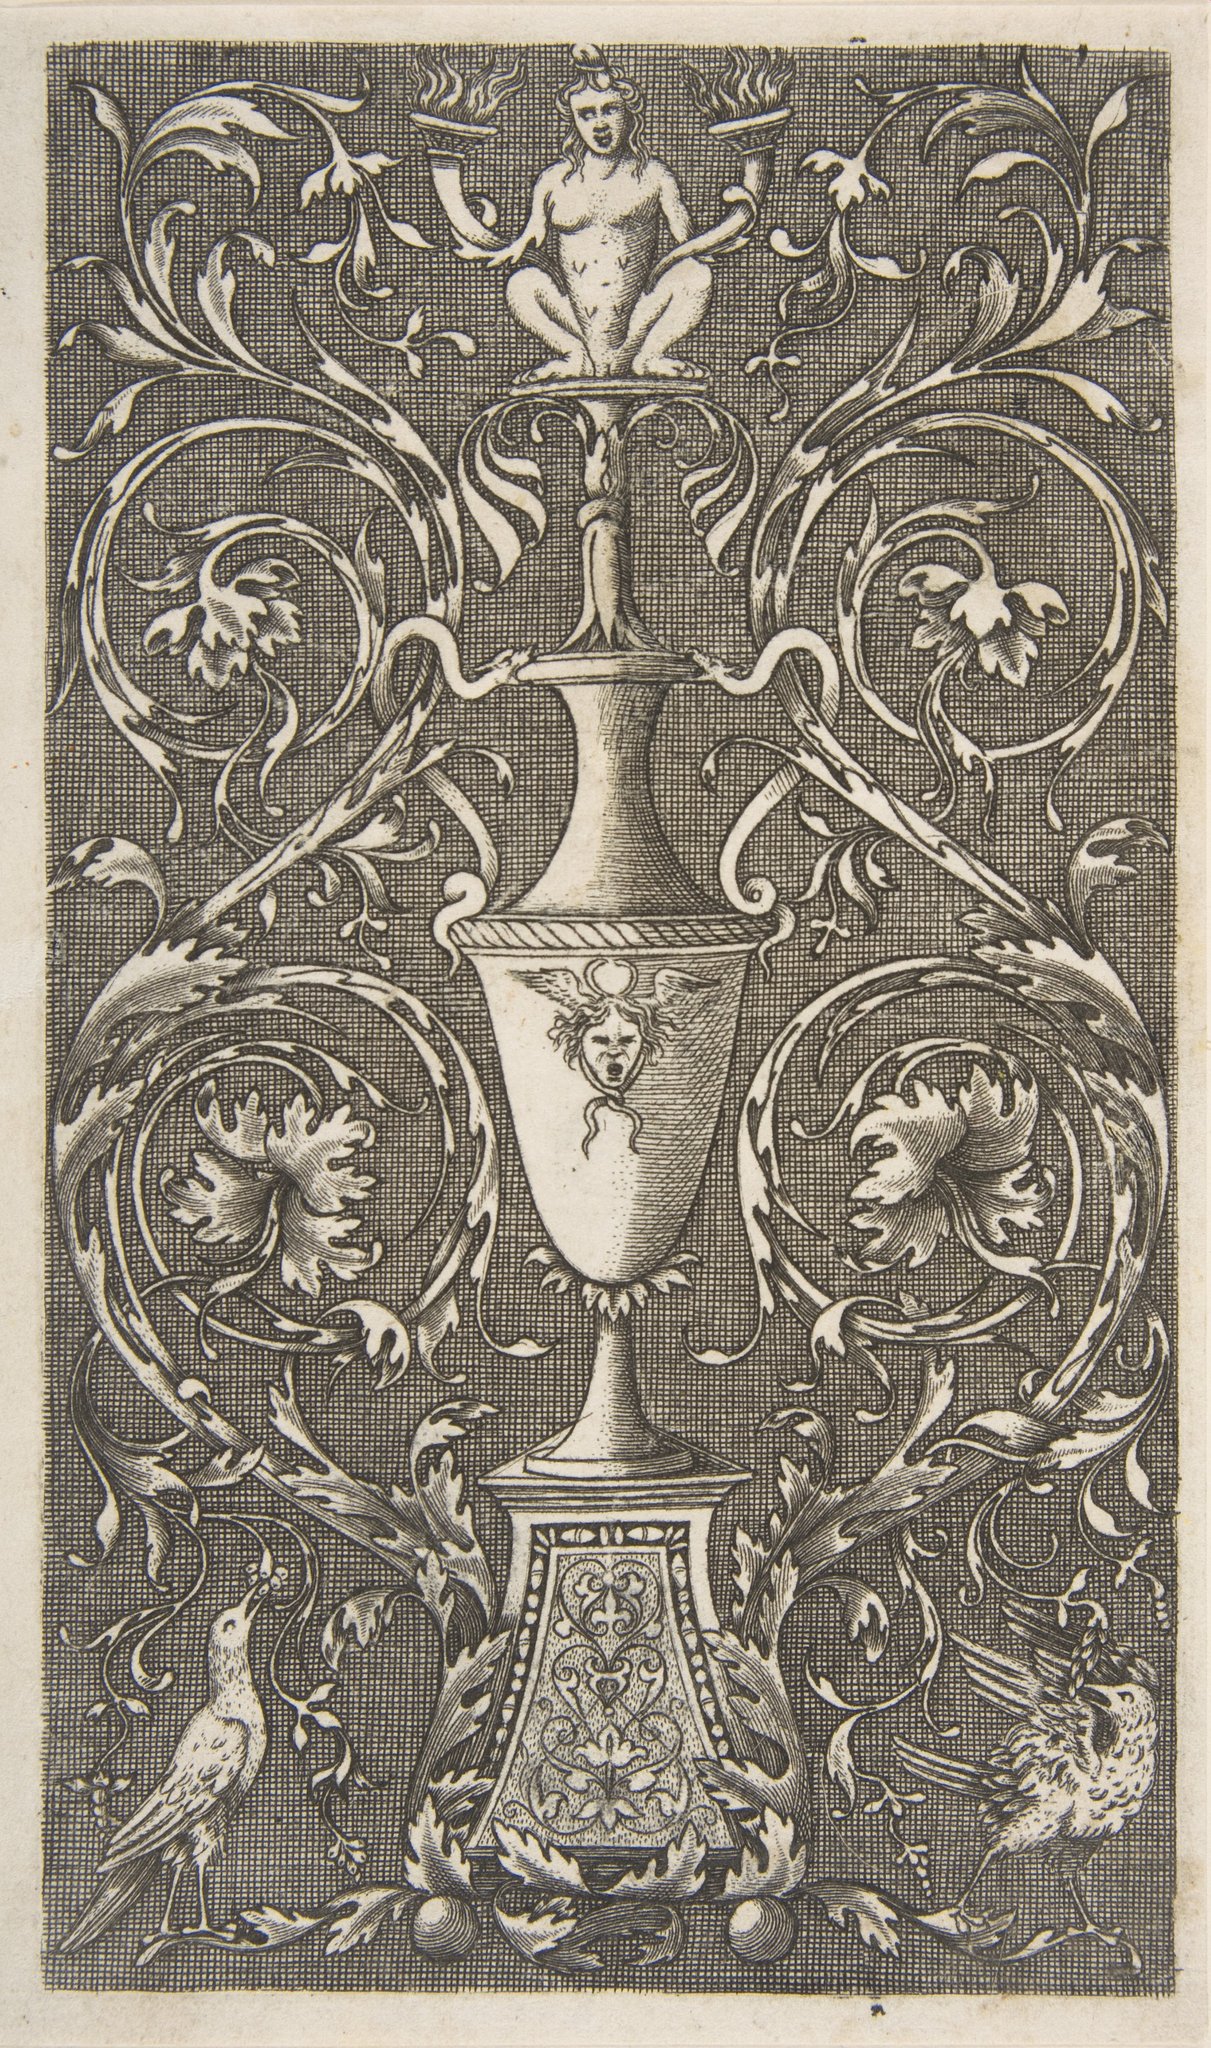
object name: print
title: Grotesque with a vase, birds and acanthus scrolls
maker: anonymous, italian, 16th to early 17th century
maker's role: artist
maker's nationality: italian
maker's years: 1500-1640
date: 1515-1600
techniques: engraving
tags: birds,grotesques,ornament,acanthus,vases